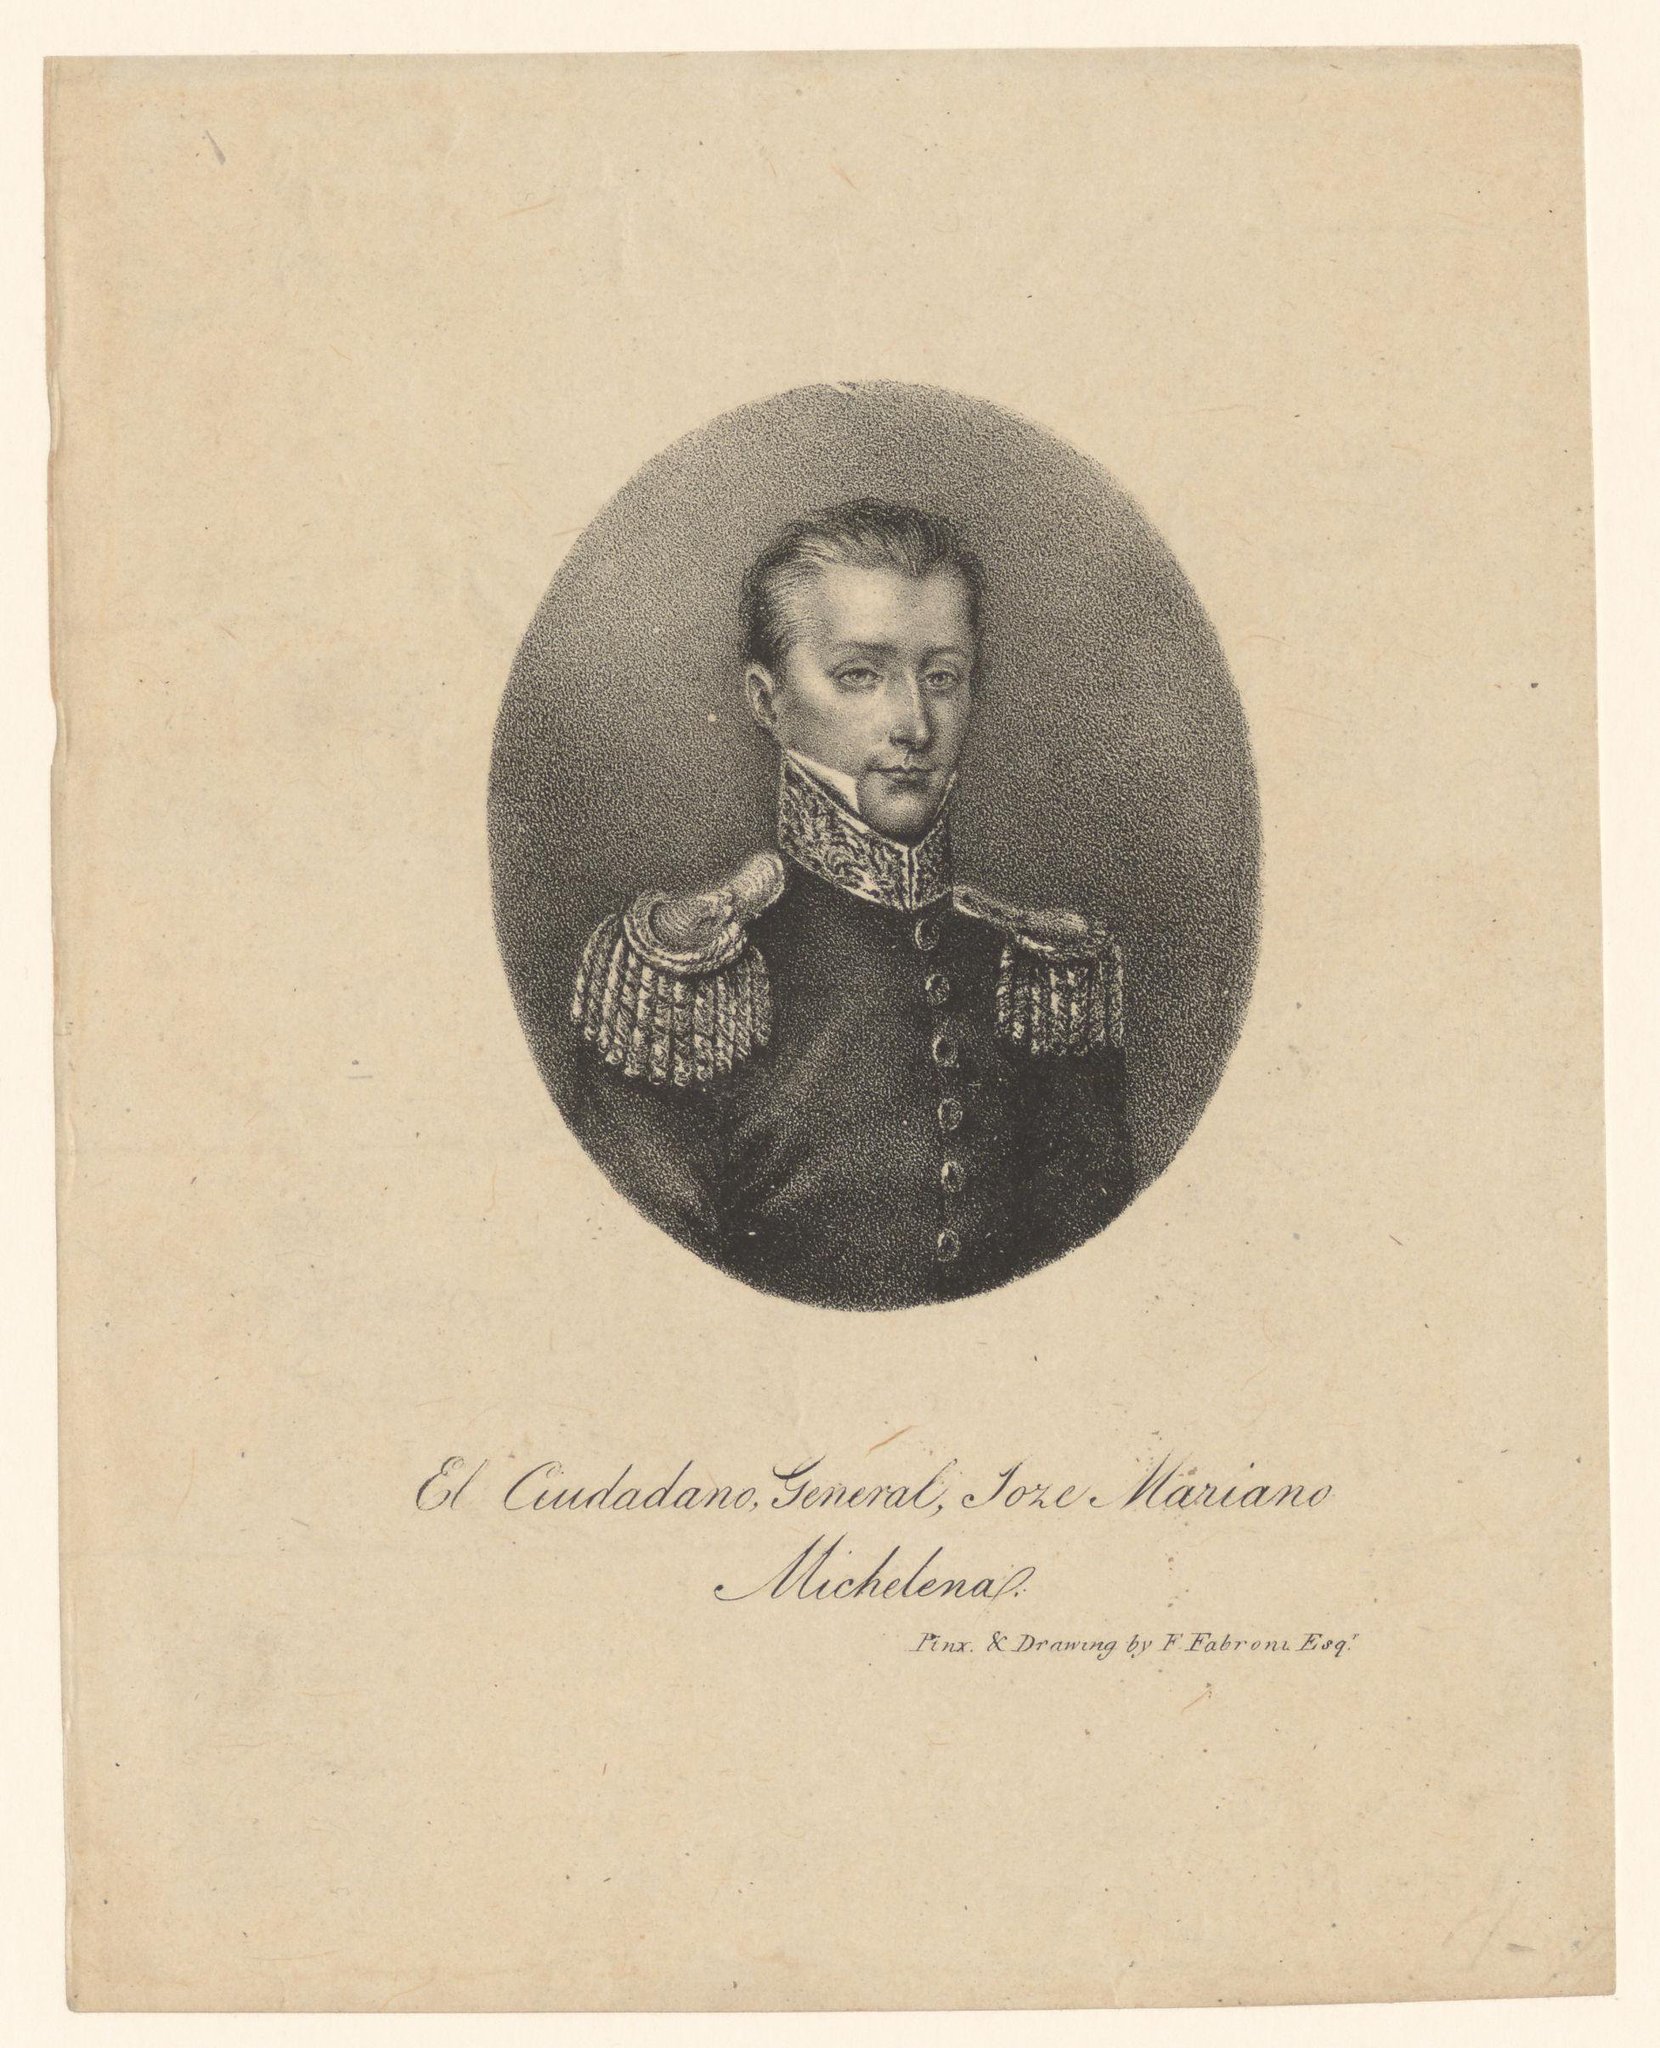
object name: print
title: Portret van José Mariano Michelena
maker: f. fabroni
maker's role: print maker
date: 1820-1850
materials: paper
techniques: lithograph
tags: politician, adult man, historical persons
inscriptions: collector's mark: Lugt 2228